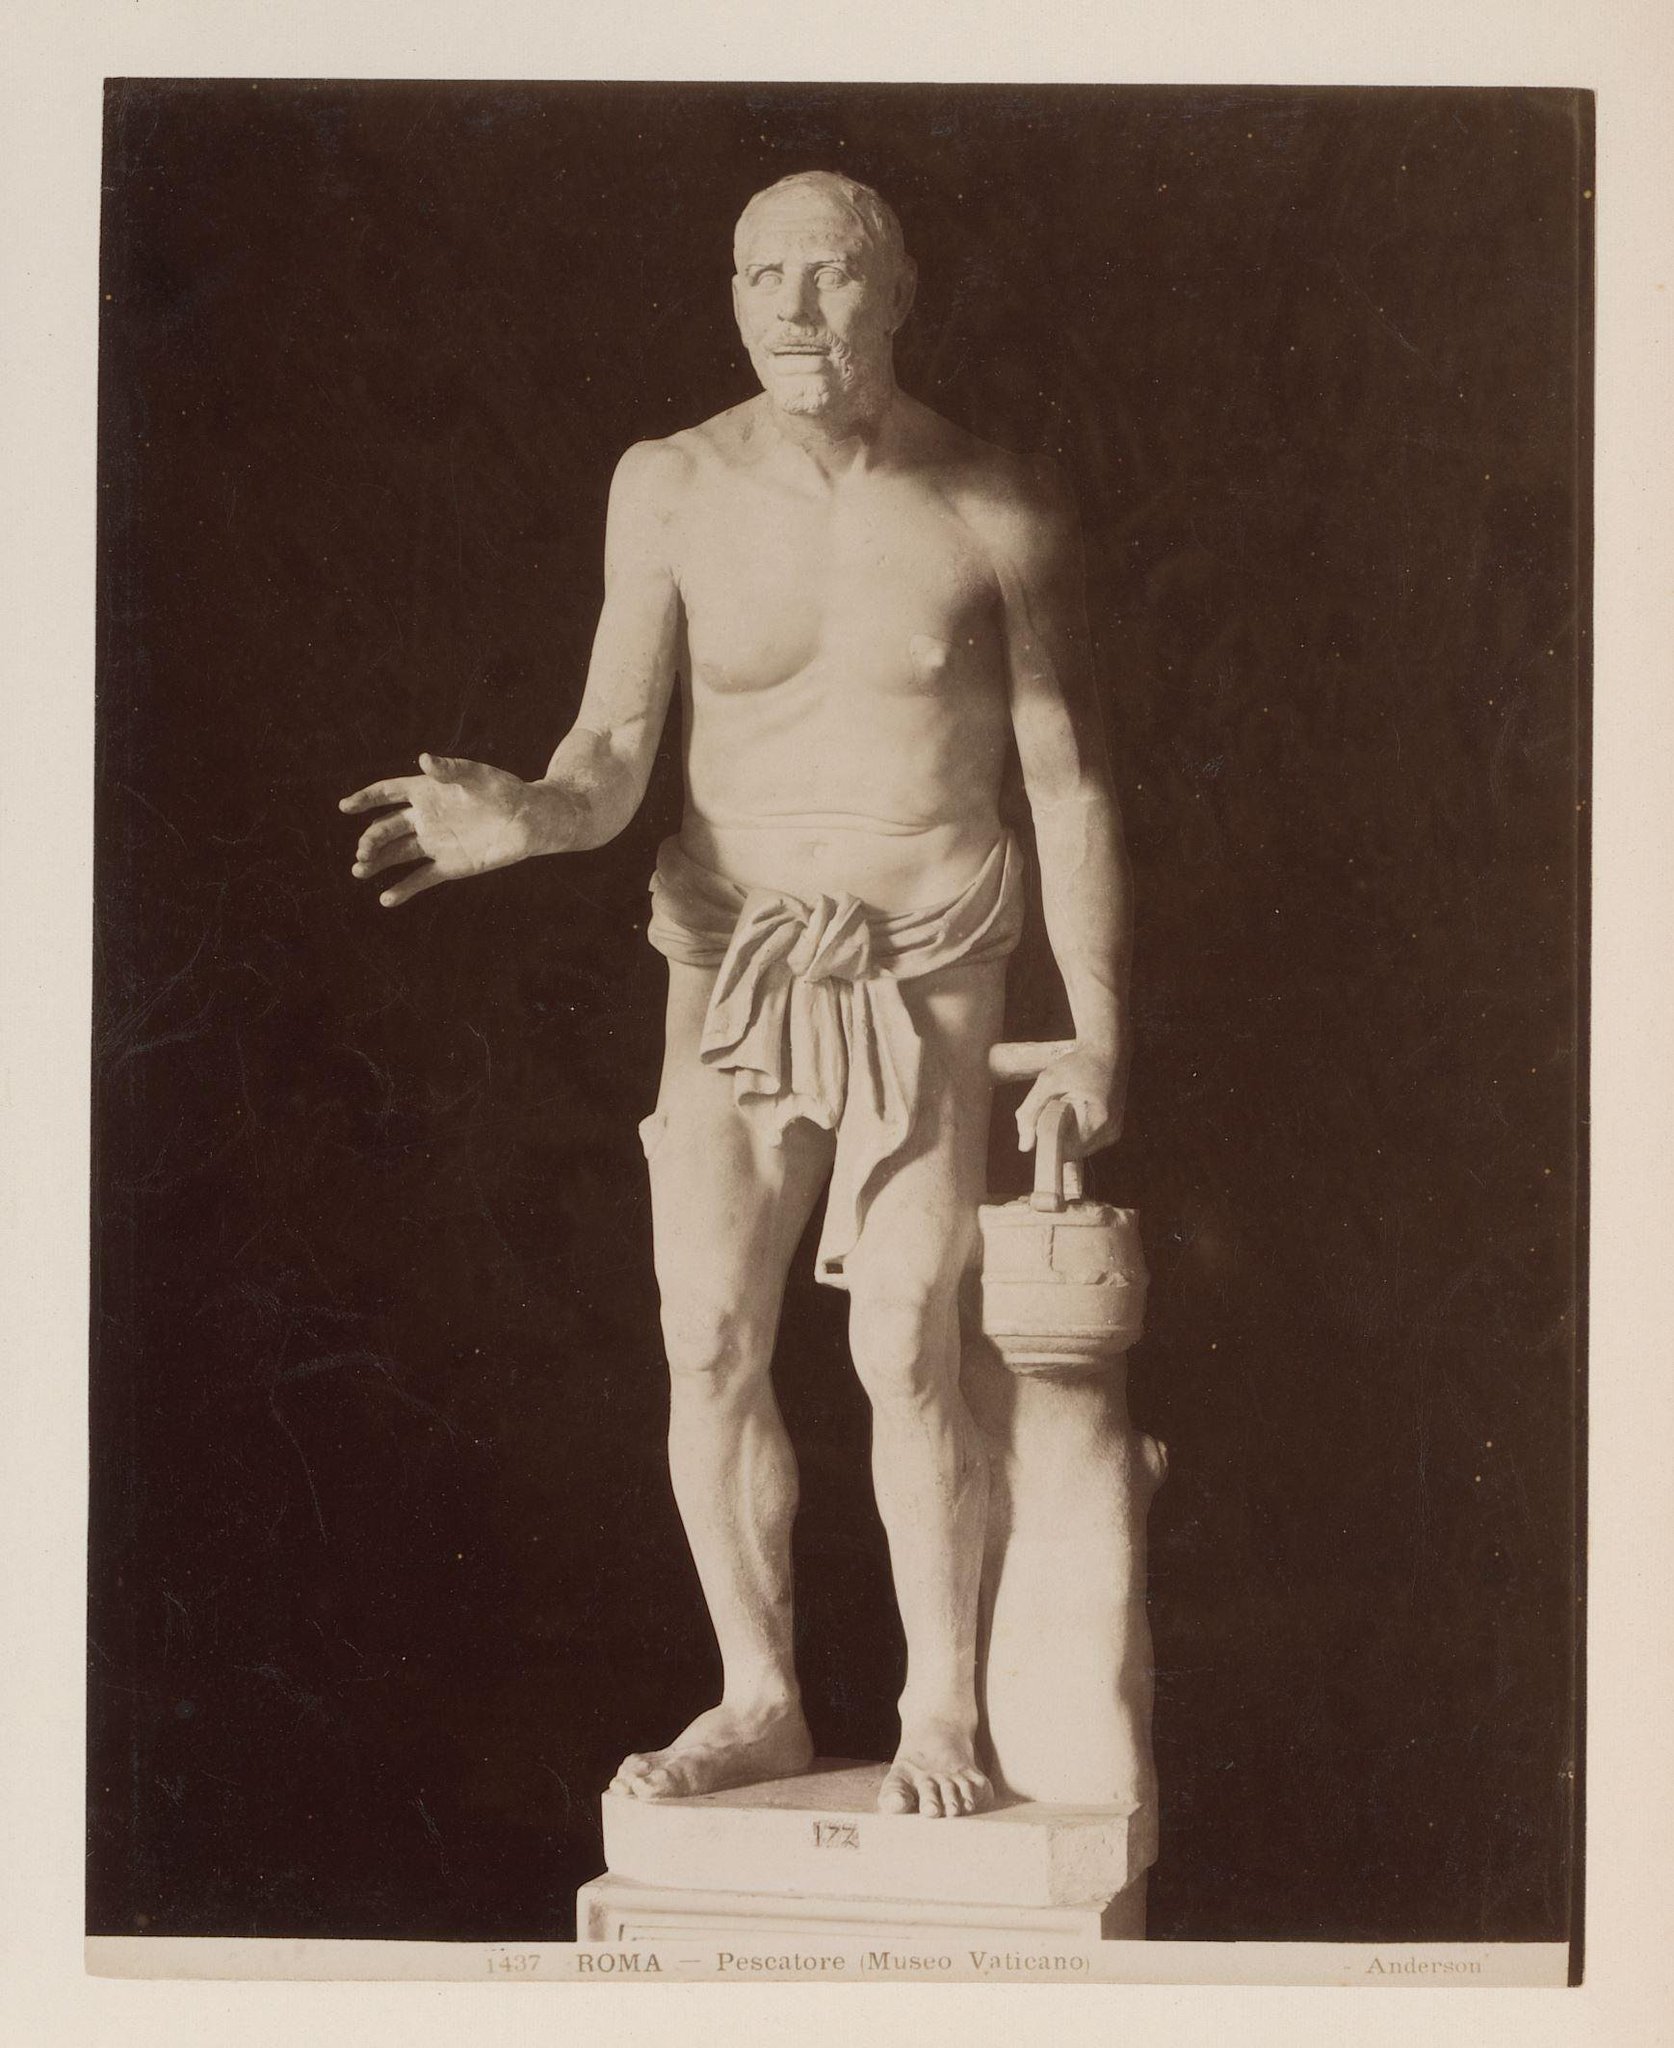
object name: album leaf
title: Pescatore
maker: james anderson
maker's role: fotograaf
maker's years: 1813-1877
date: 1857-1875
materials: paper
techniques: albumen print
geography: vatican museums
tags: piece of sculpture, reproduction of a piece of sculpture, fisherman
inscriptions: inscription: ‘1437 - ROMA - Pescatore (Museo Vaticano) - Anderson’